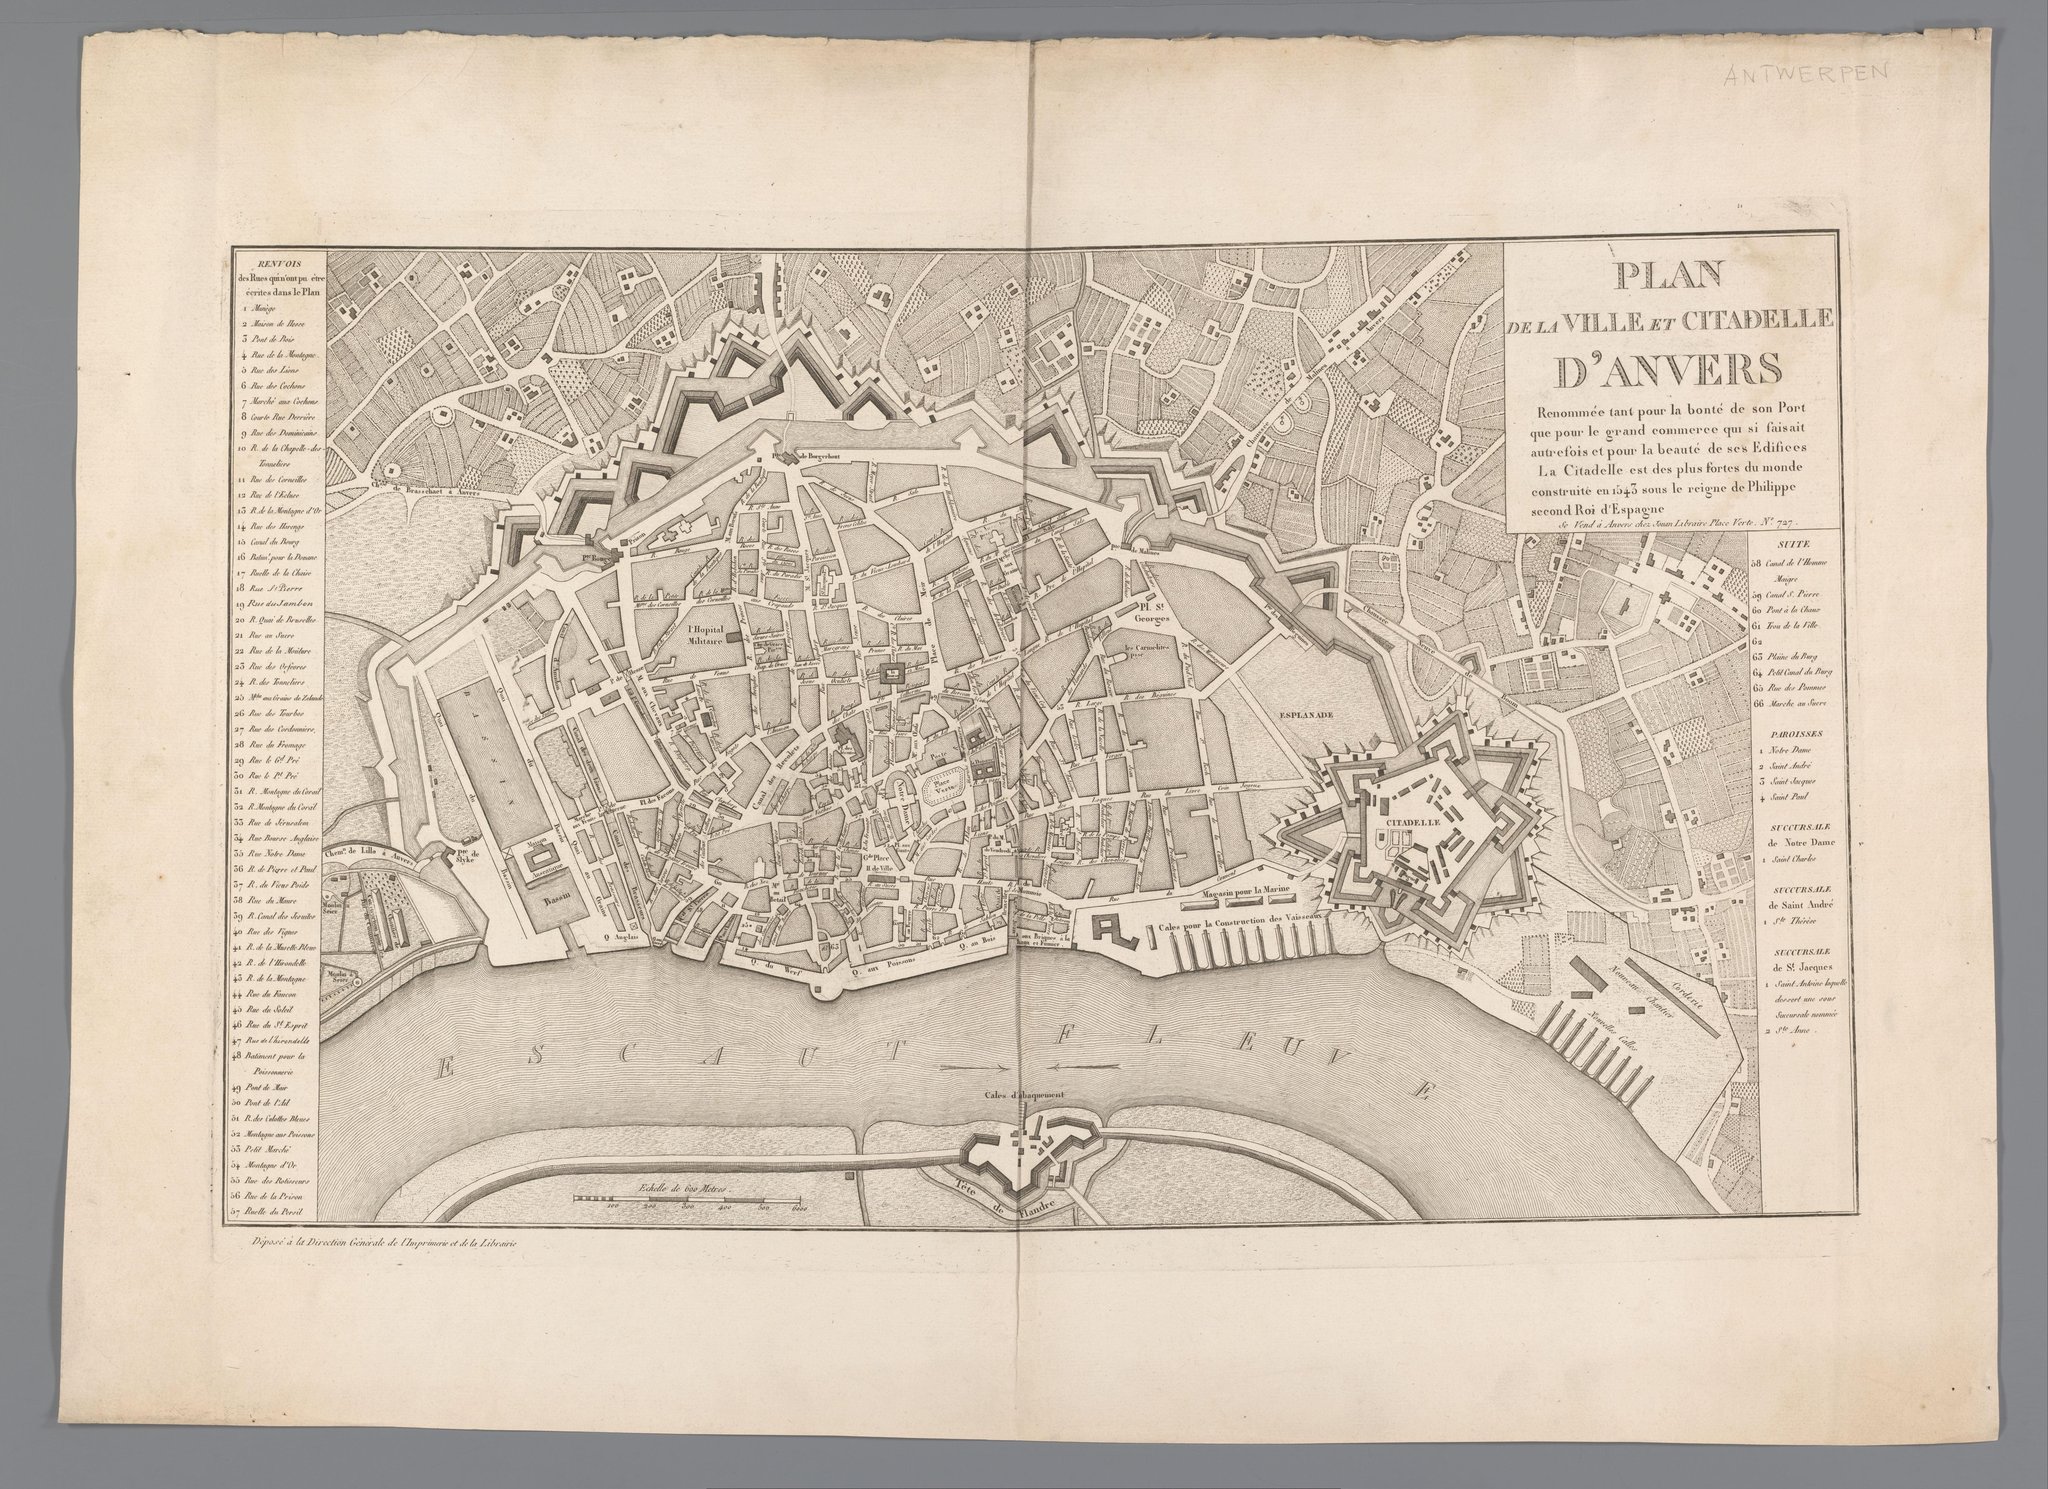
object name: print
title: Plan de la Ville et Citadelle D'Anvers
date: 1700-1749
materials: paper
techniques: etching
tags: maps of cities, antwerp